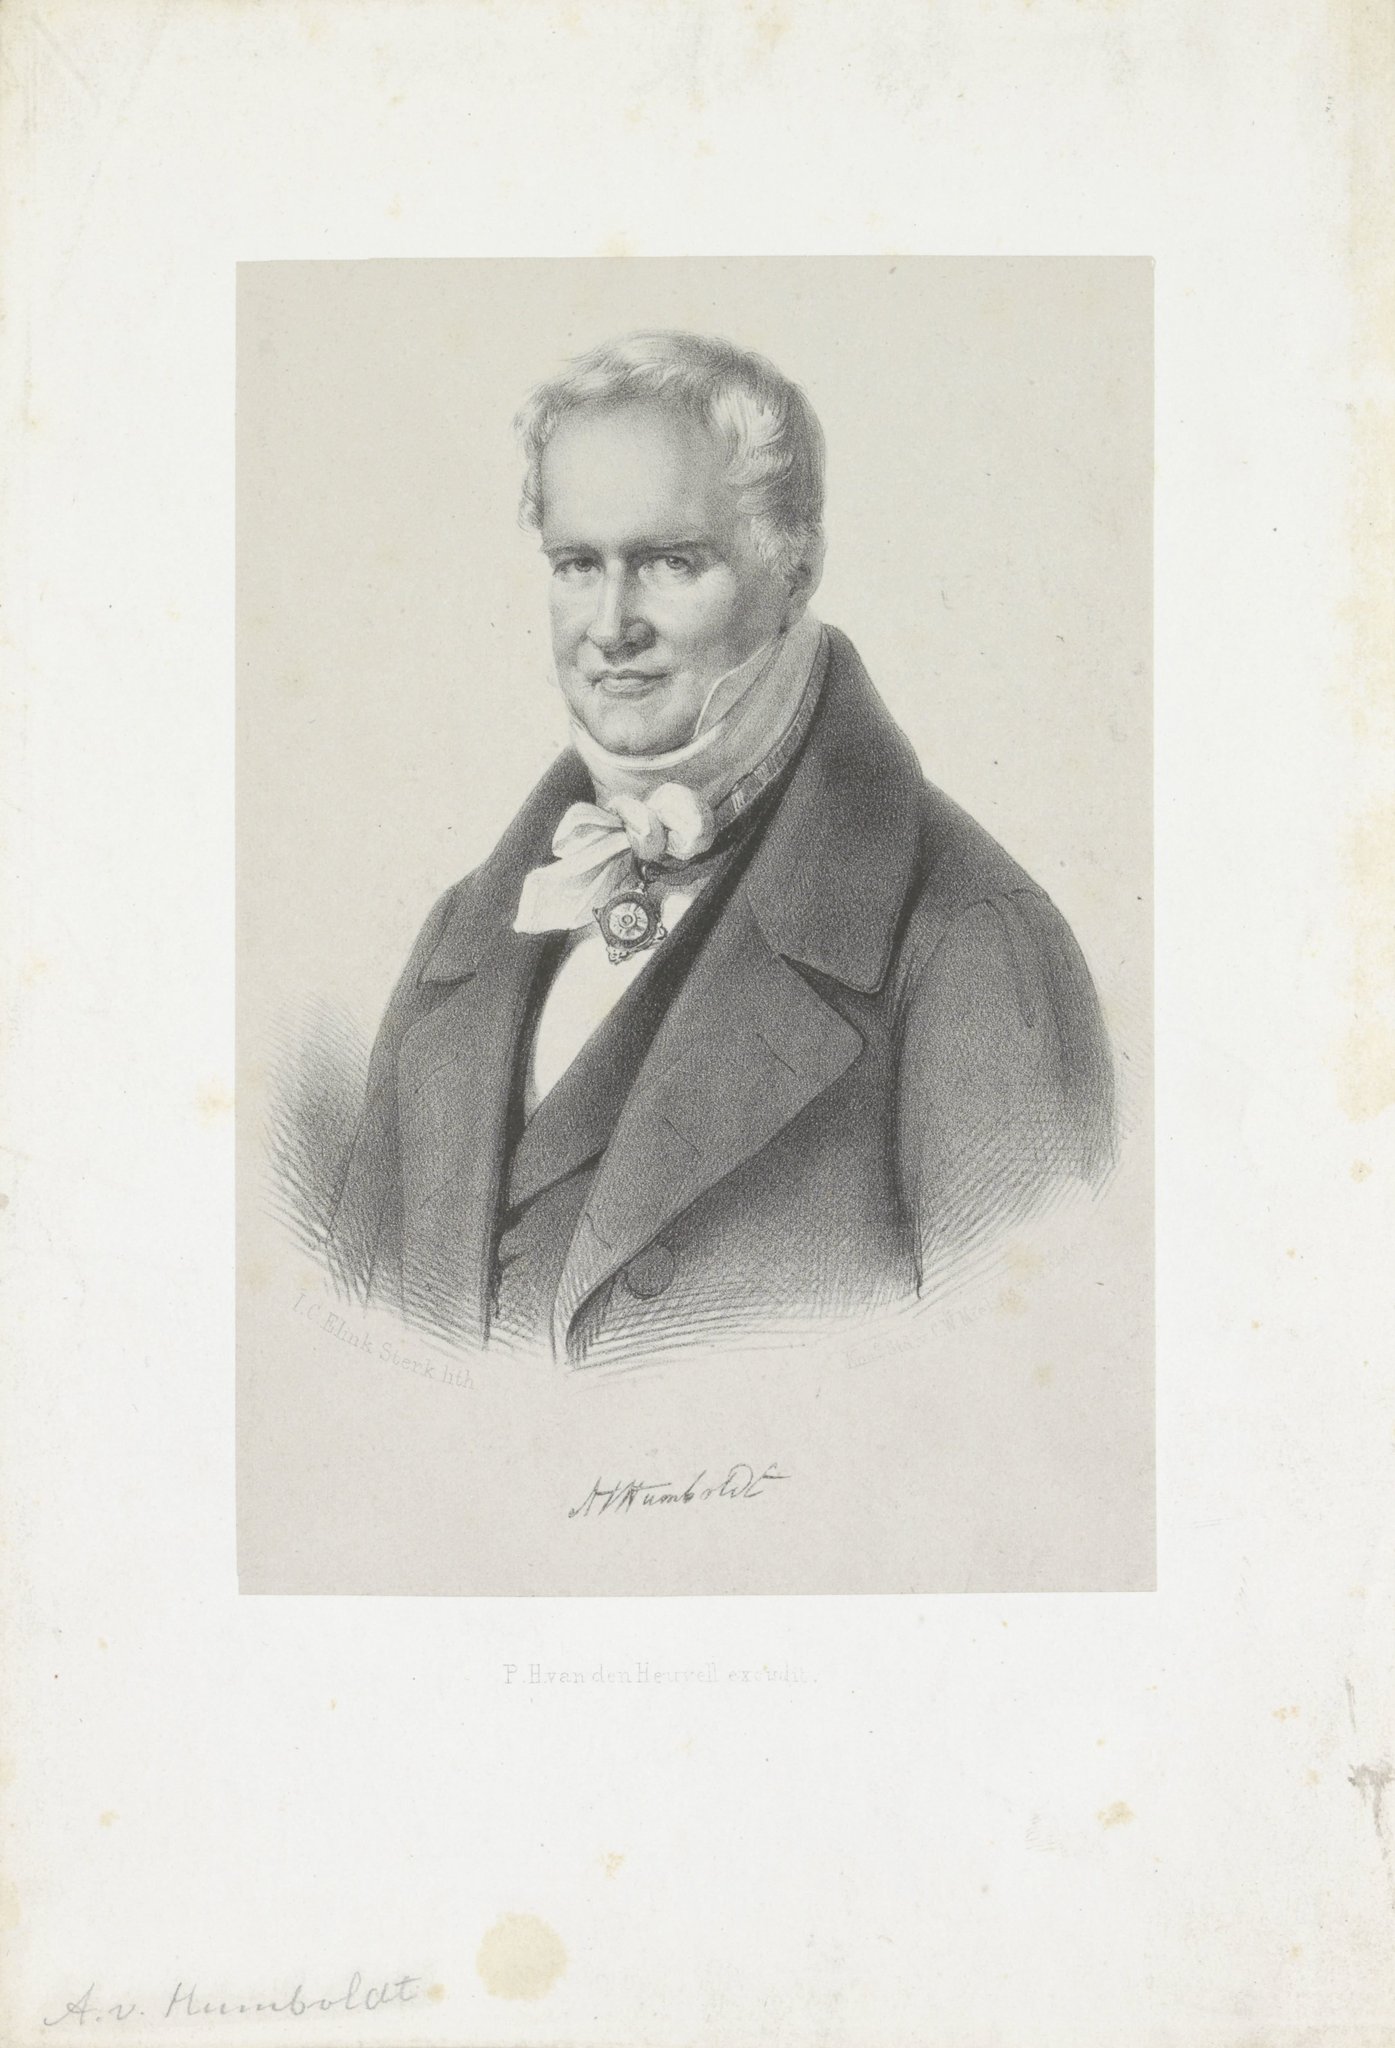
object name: print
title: Portret van Alexander von Humboldt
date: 1818-1871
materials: paper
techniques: lithograph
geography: the hague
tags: knighthood order, historical persons (+ (full) bust portrait)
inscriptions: collector's mark: Lugt 2228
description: De geportretteerde draagt een witte gestrikte das en een ridderorde om zijn hals. Onder het portret zijn signatuur.